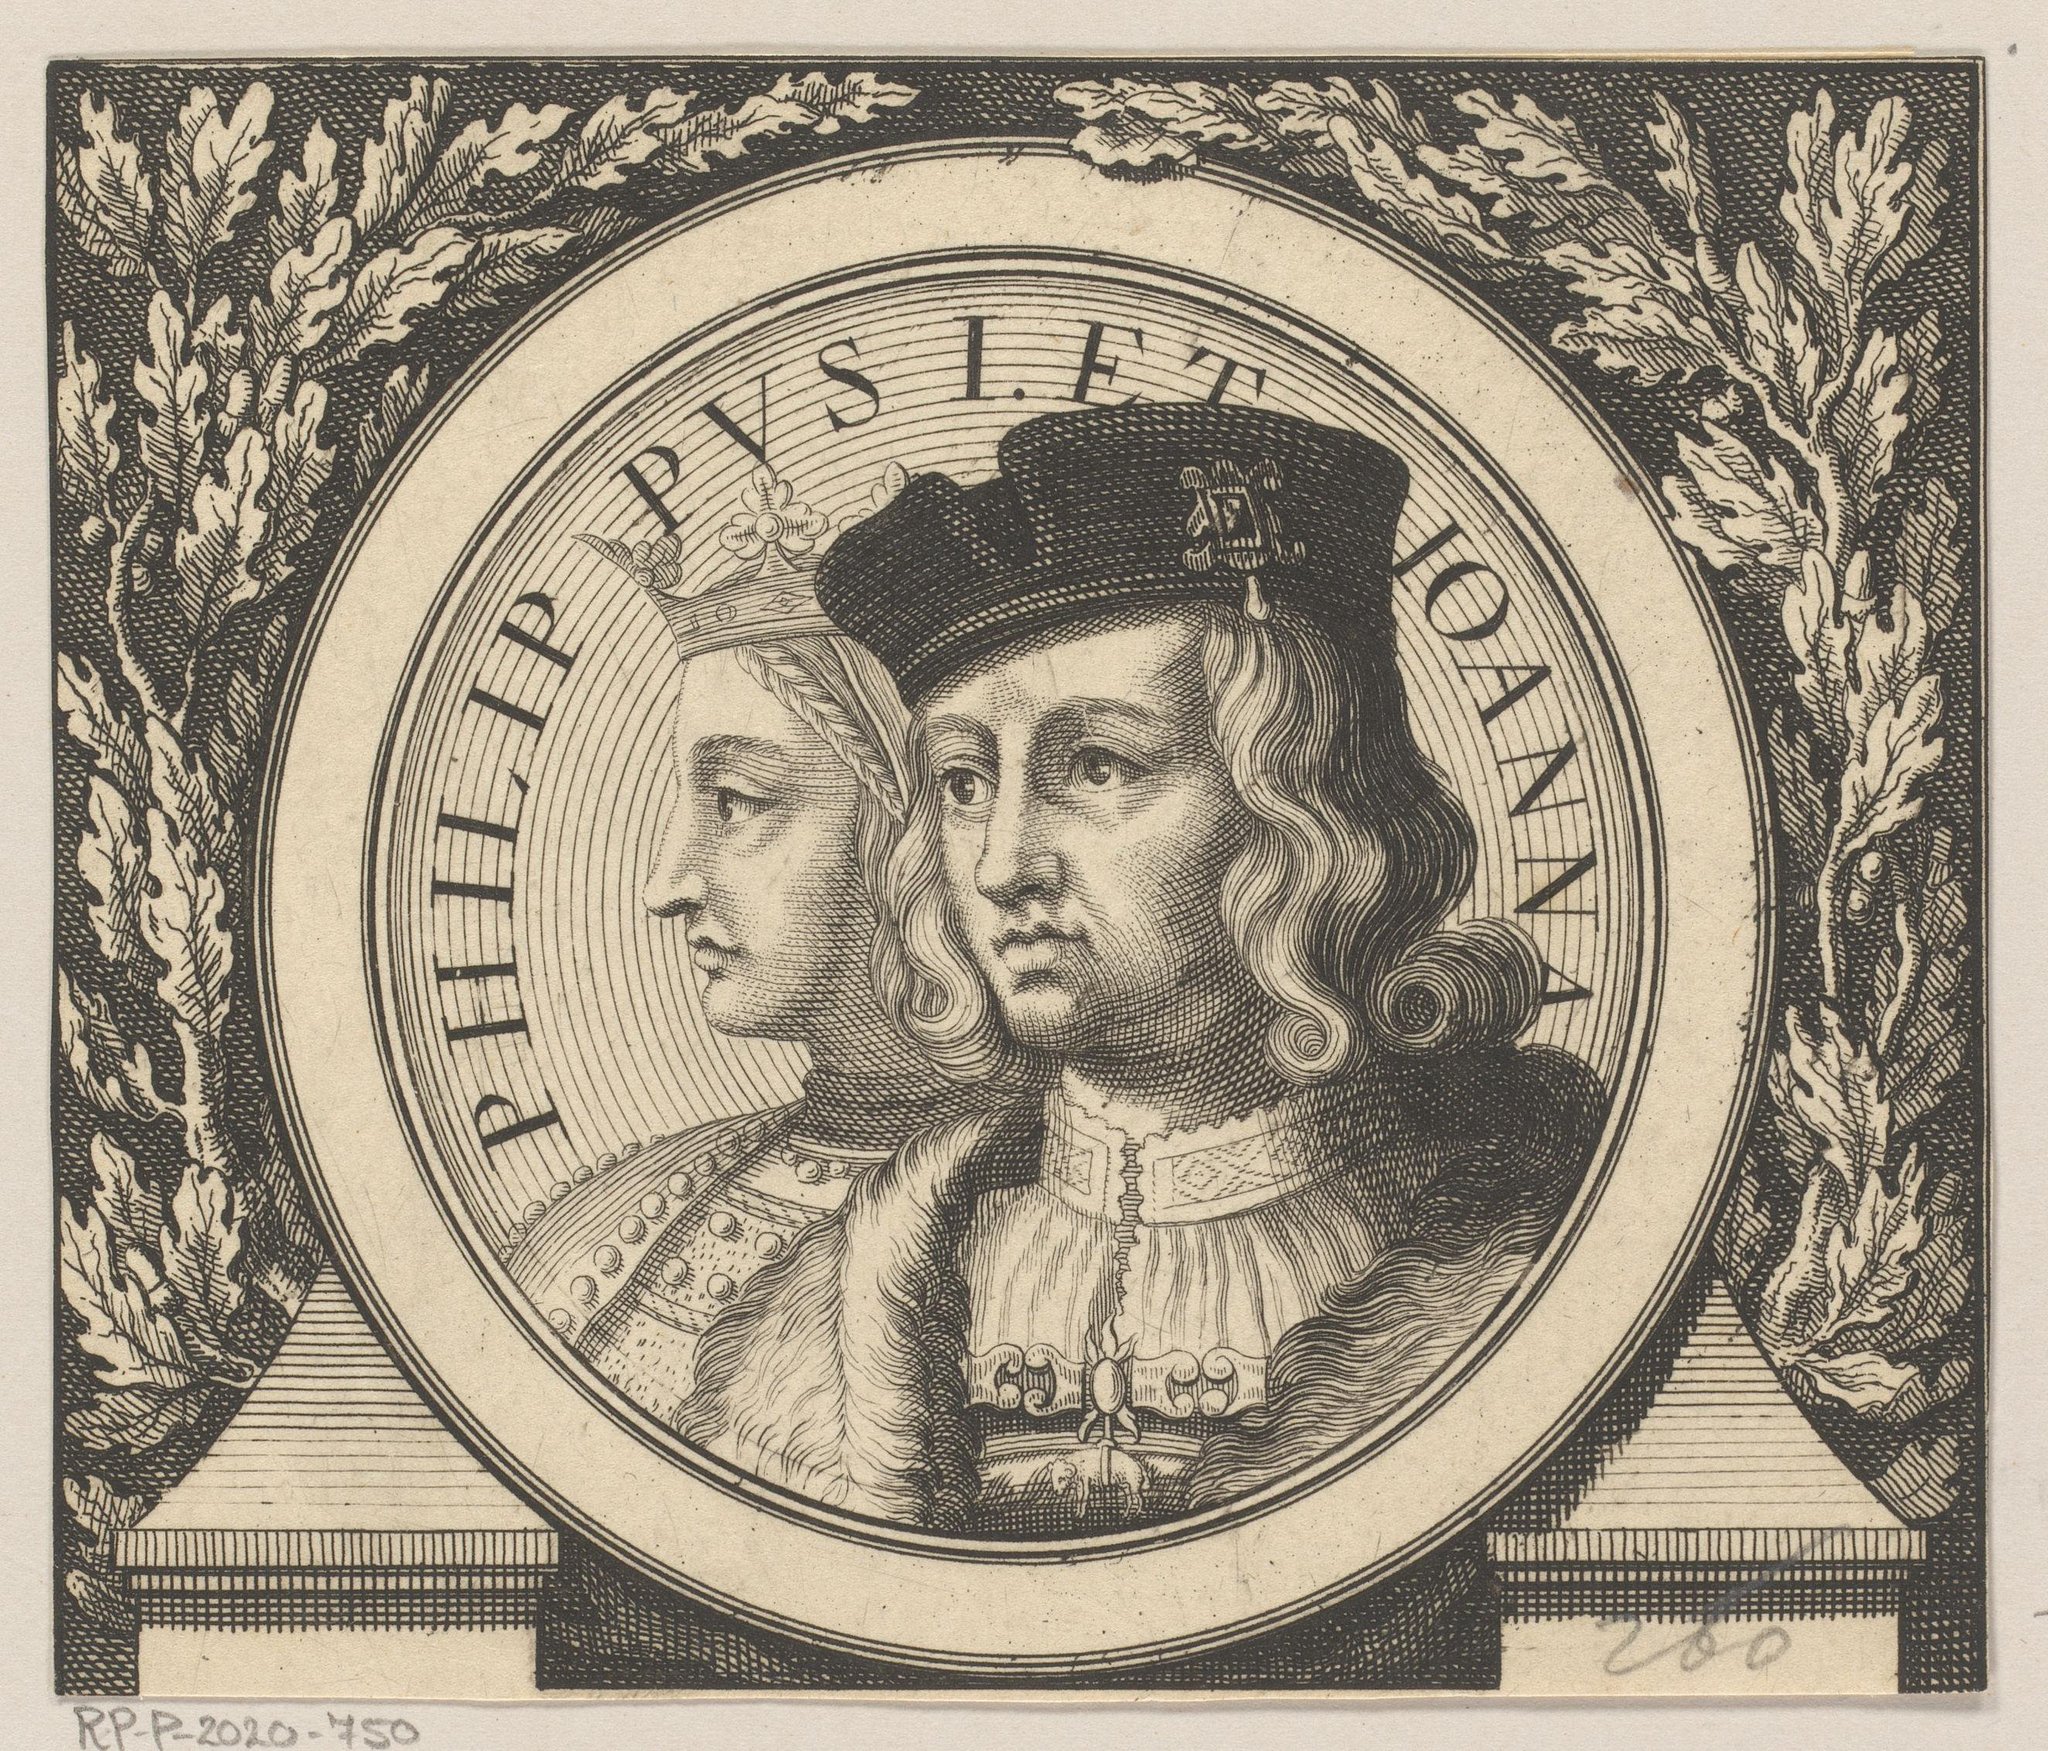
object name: print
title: Philipus I. et Joanna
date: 1698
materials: paper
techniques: engraving, etching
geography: paris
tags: filips de schone (hertog van bourgondië), historical persons - bb - woman, historical persons, queen, ruler, sovereign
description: Portret afkomstig van een grote prent, getiteld 'Series Chronologica et Imagines Regum Hispaniae ab Ataulpho ad Carolum II', bestaande uit meerdere bladen die samengevoegd konden worden, uitgegeven door Petrus de la Tour in 1698.